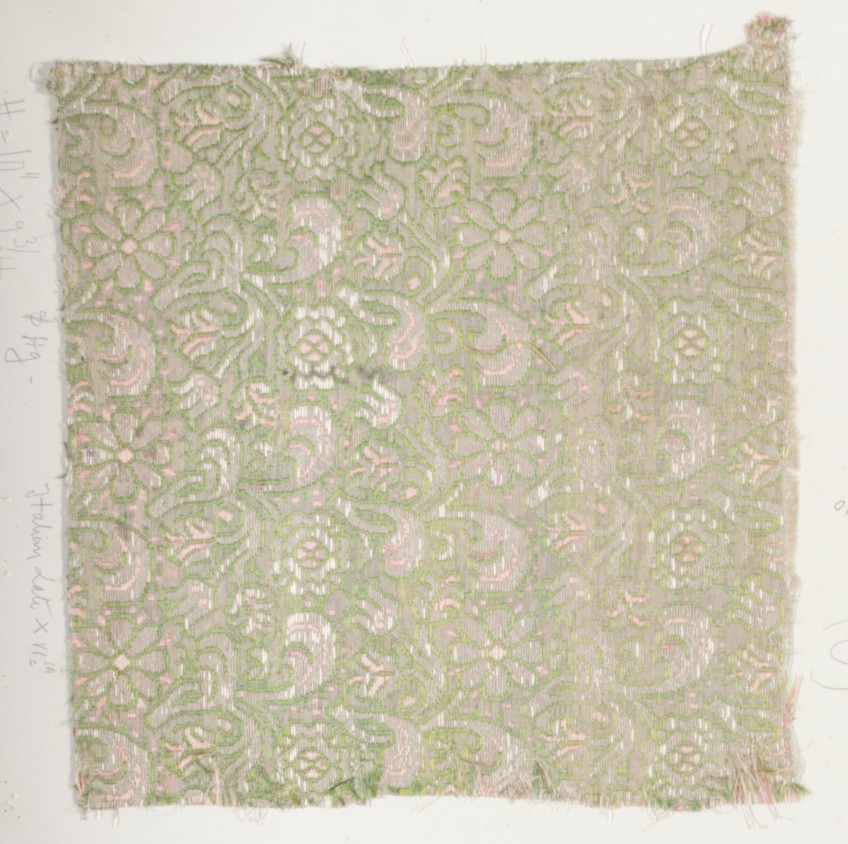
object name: fragment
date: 1567-1600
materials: metal thread, silk